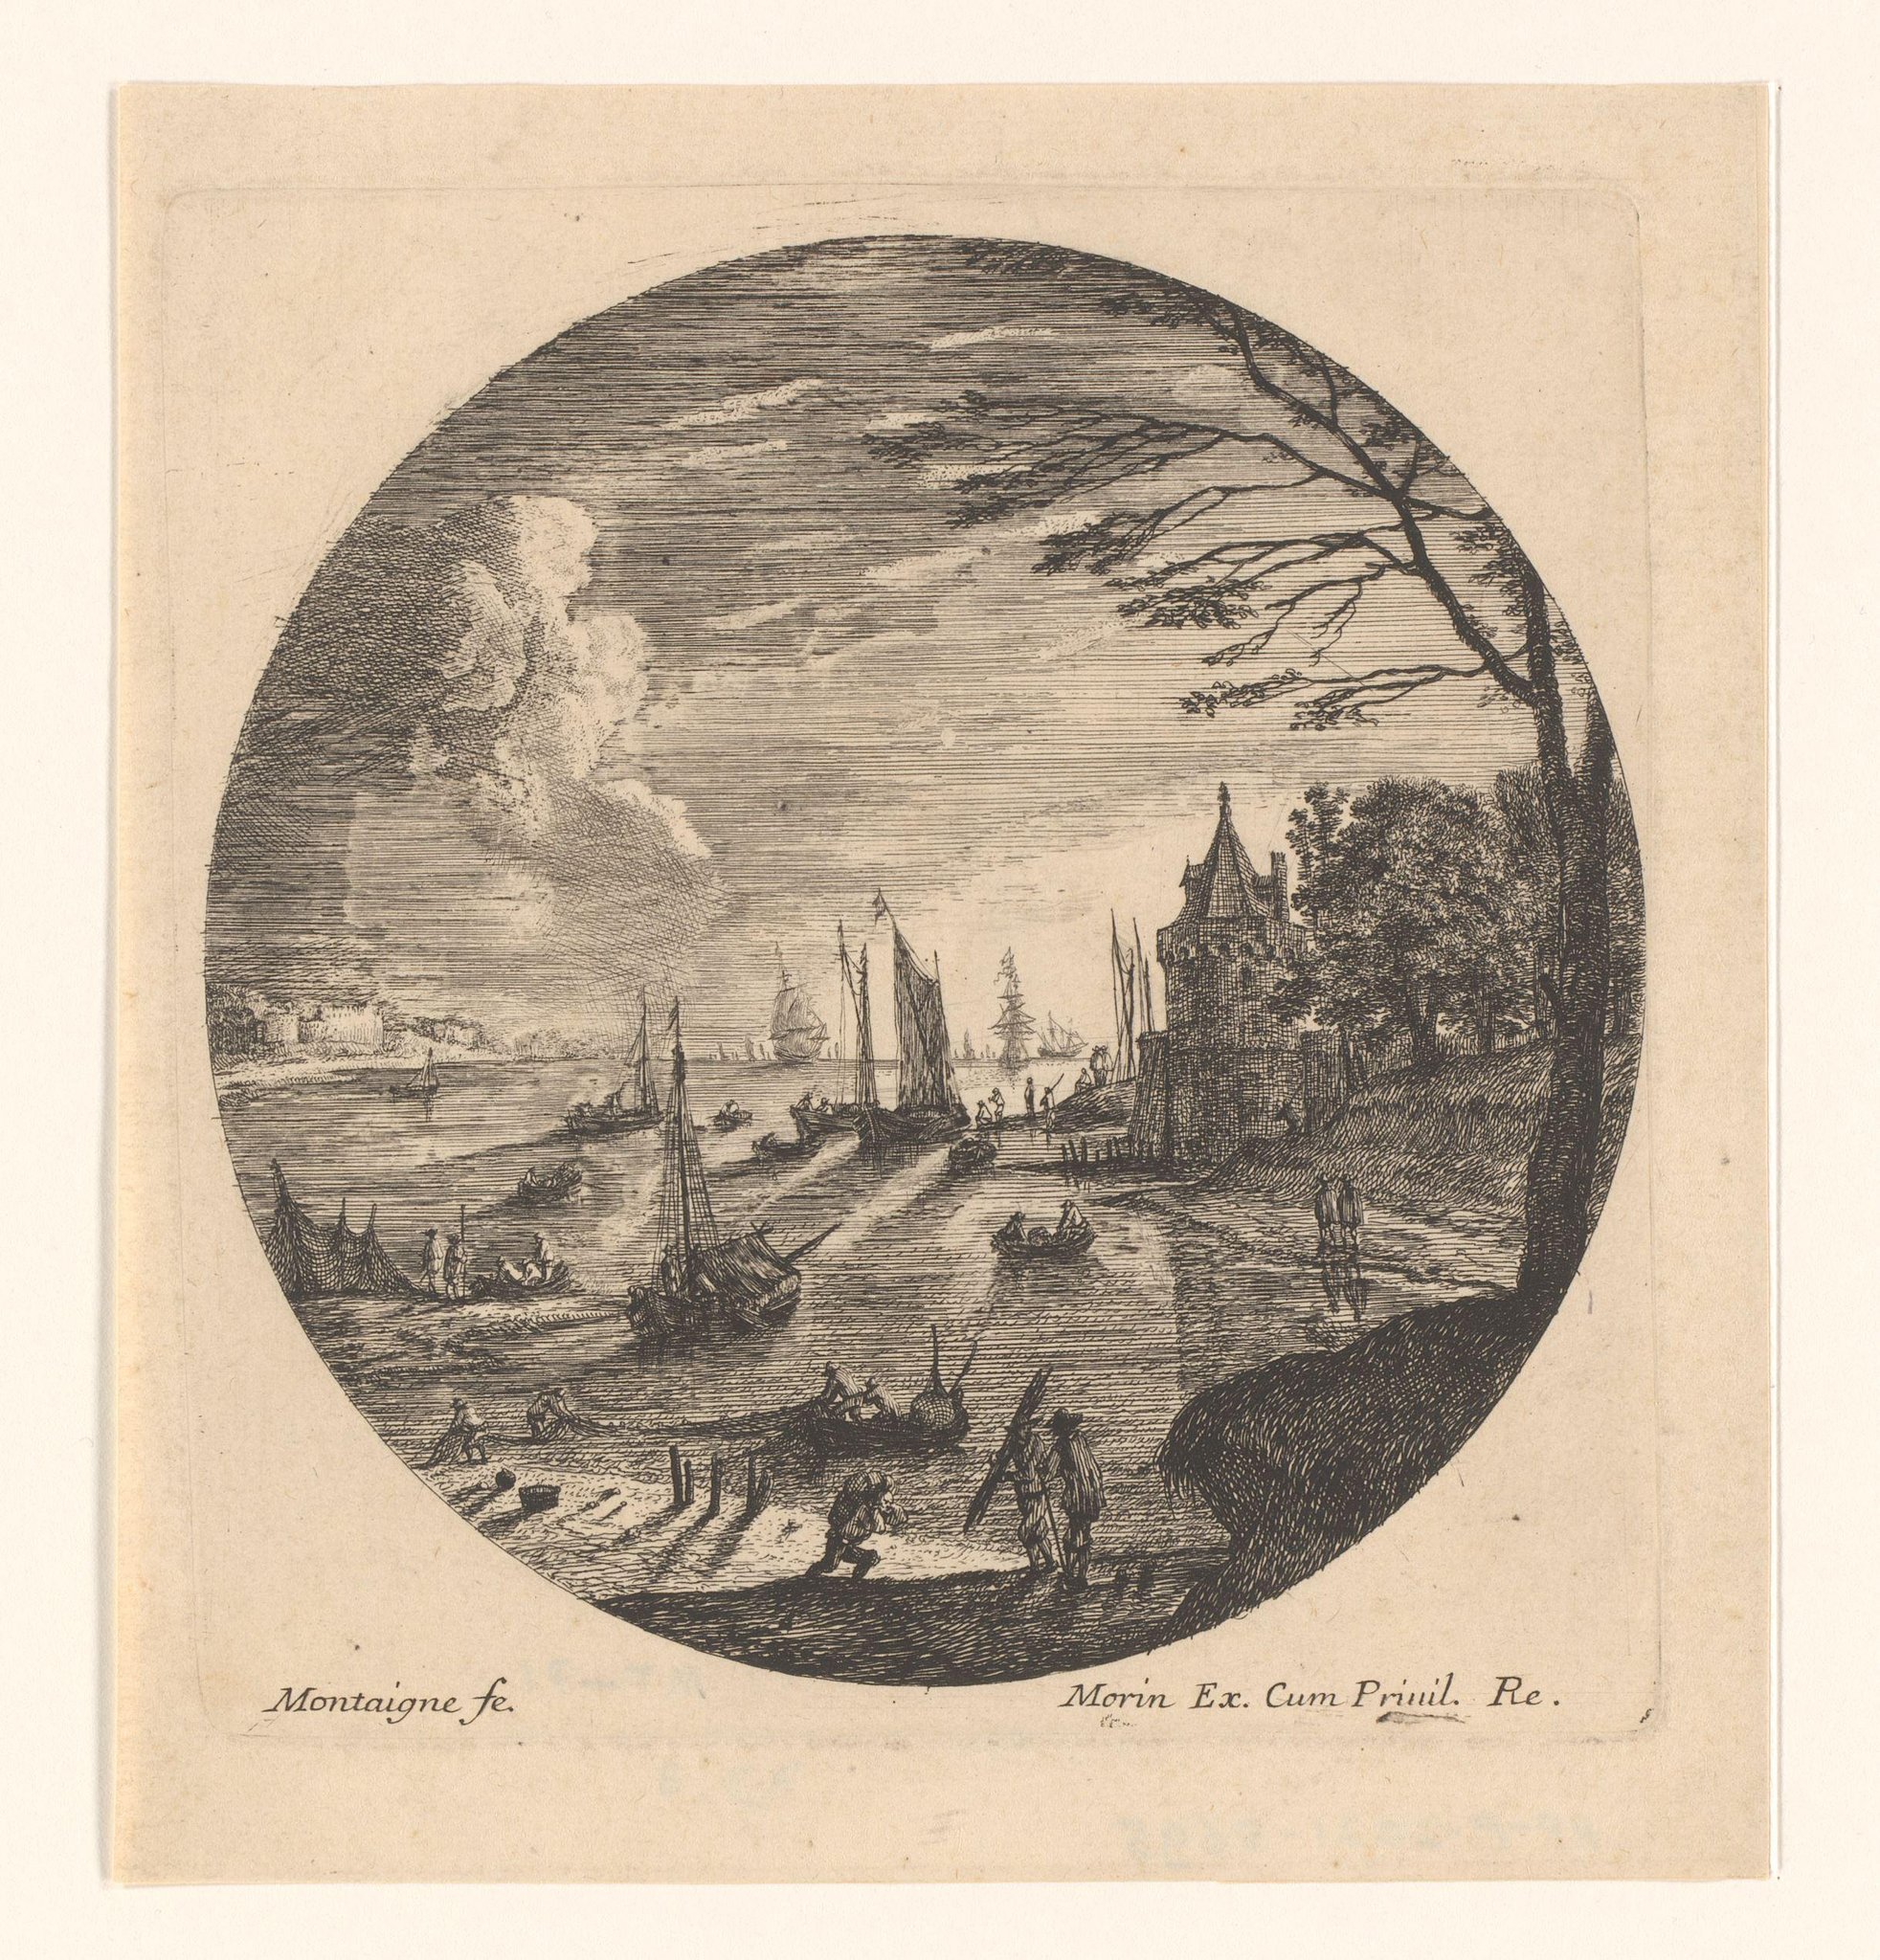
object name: print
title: Havengezicht met zonsondergang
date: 1625-1650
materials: paper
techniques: etching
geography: paris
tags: harbour, sailing-ship, sailing-boat, landscape with tower or castle, sunset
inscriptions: inscription: ‘MT-PI’